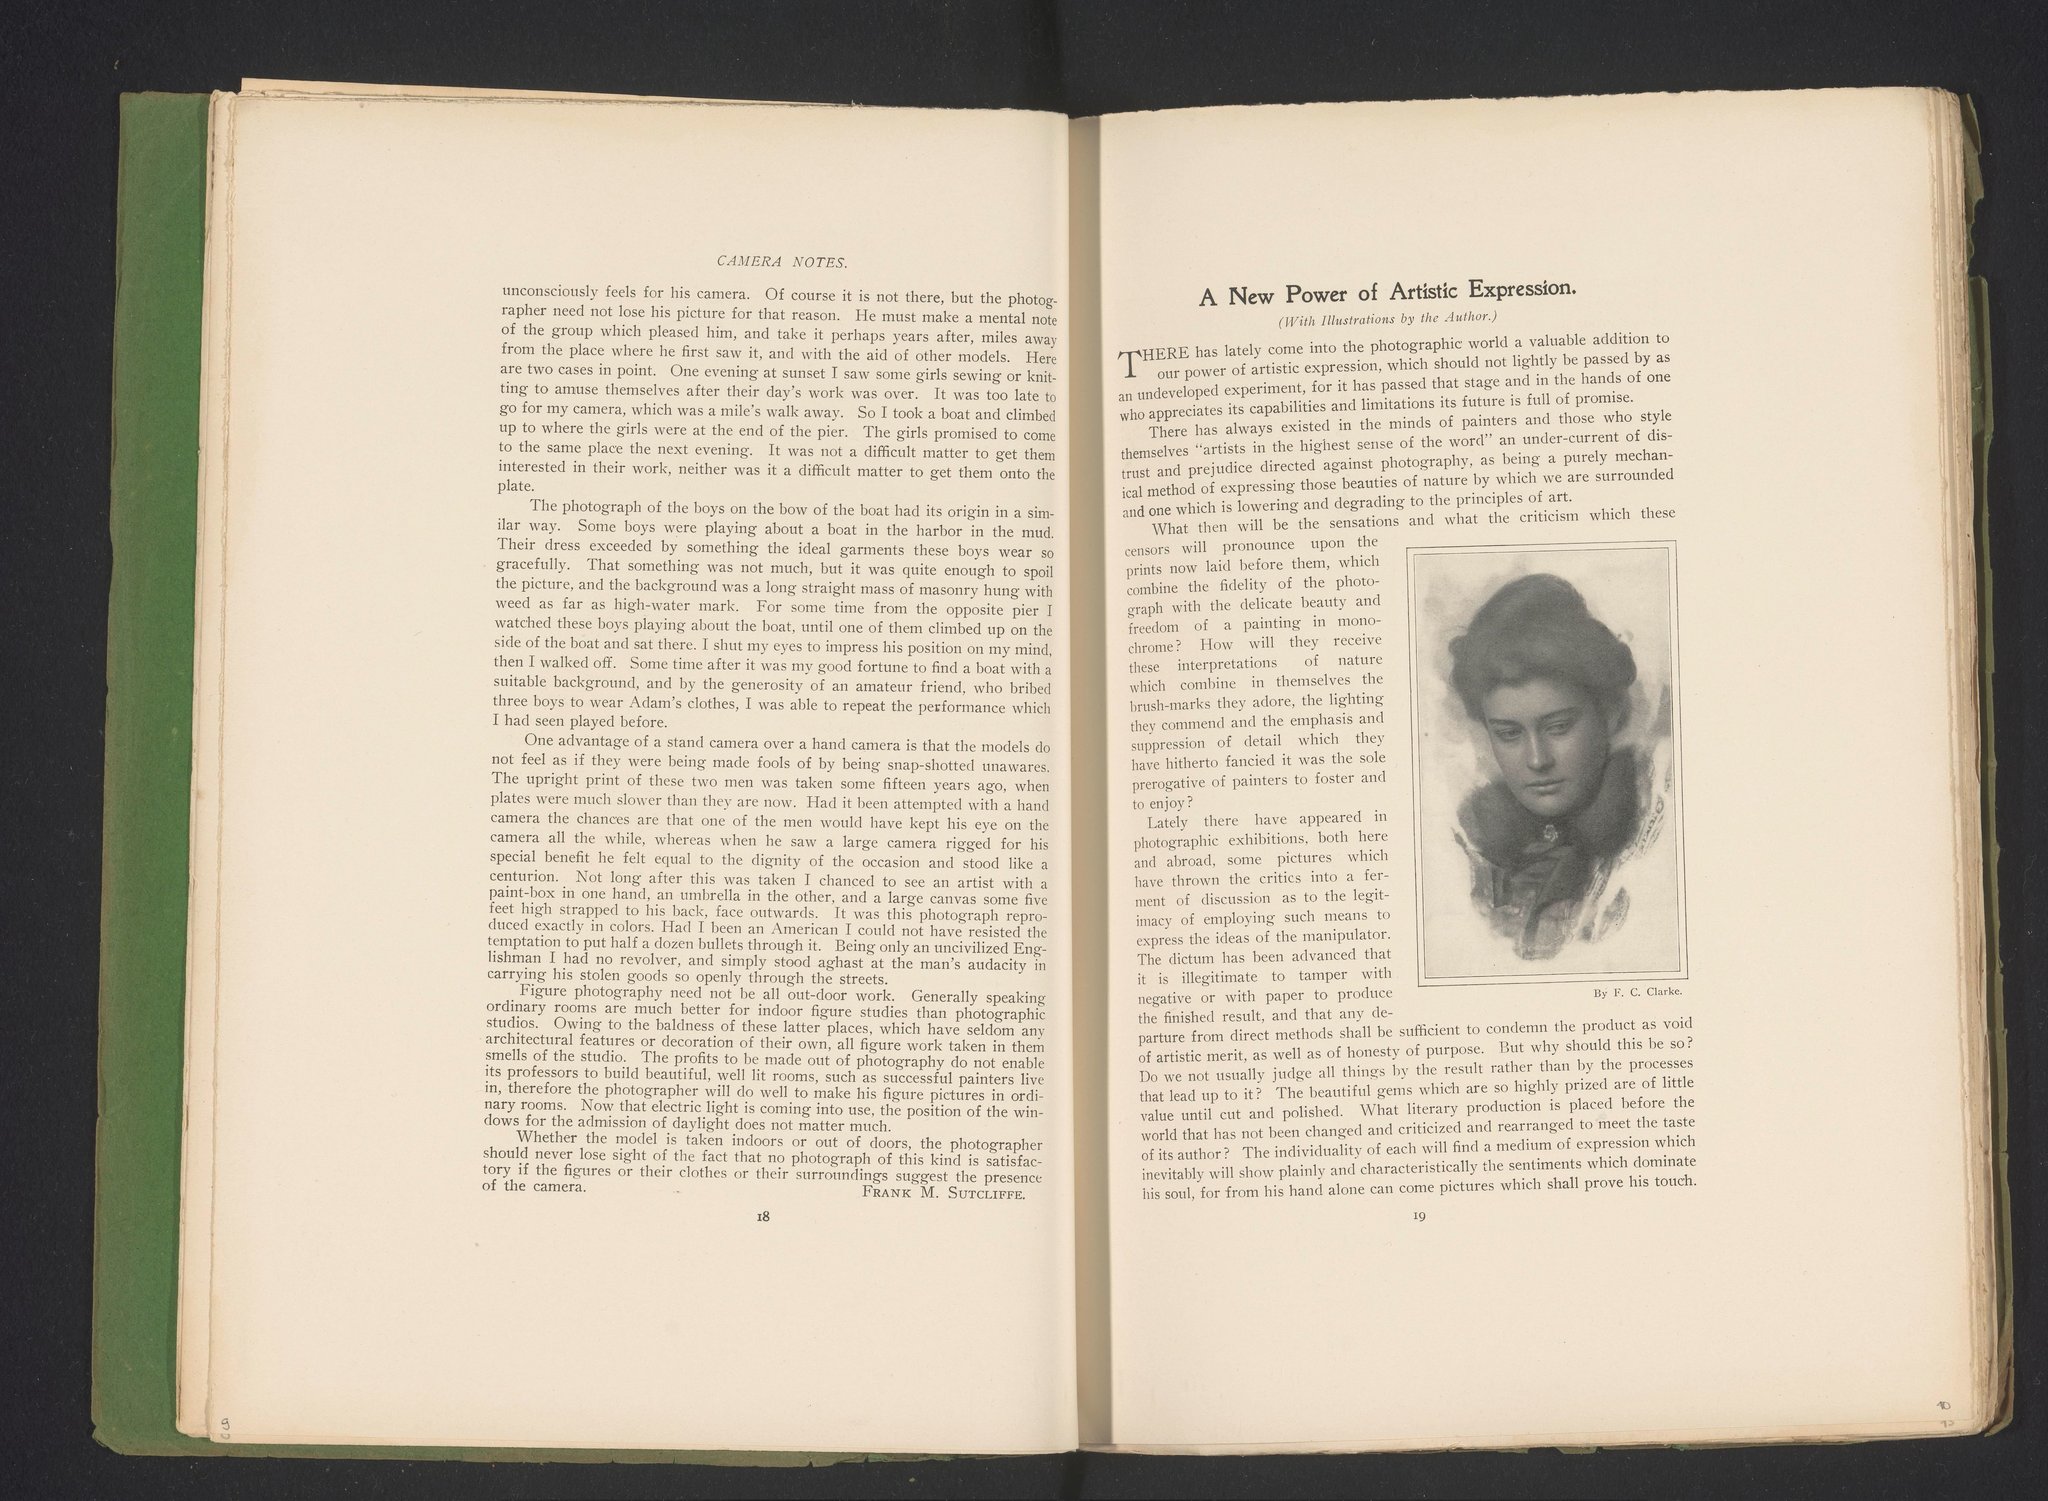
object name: photomechanical print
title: Portret van een onbekende vrouw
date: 1896-1901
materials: paper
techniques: autotype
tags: historical persons not known by name - bb - woman